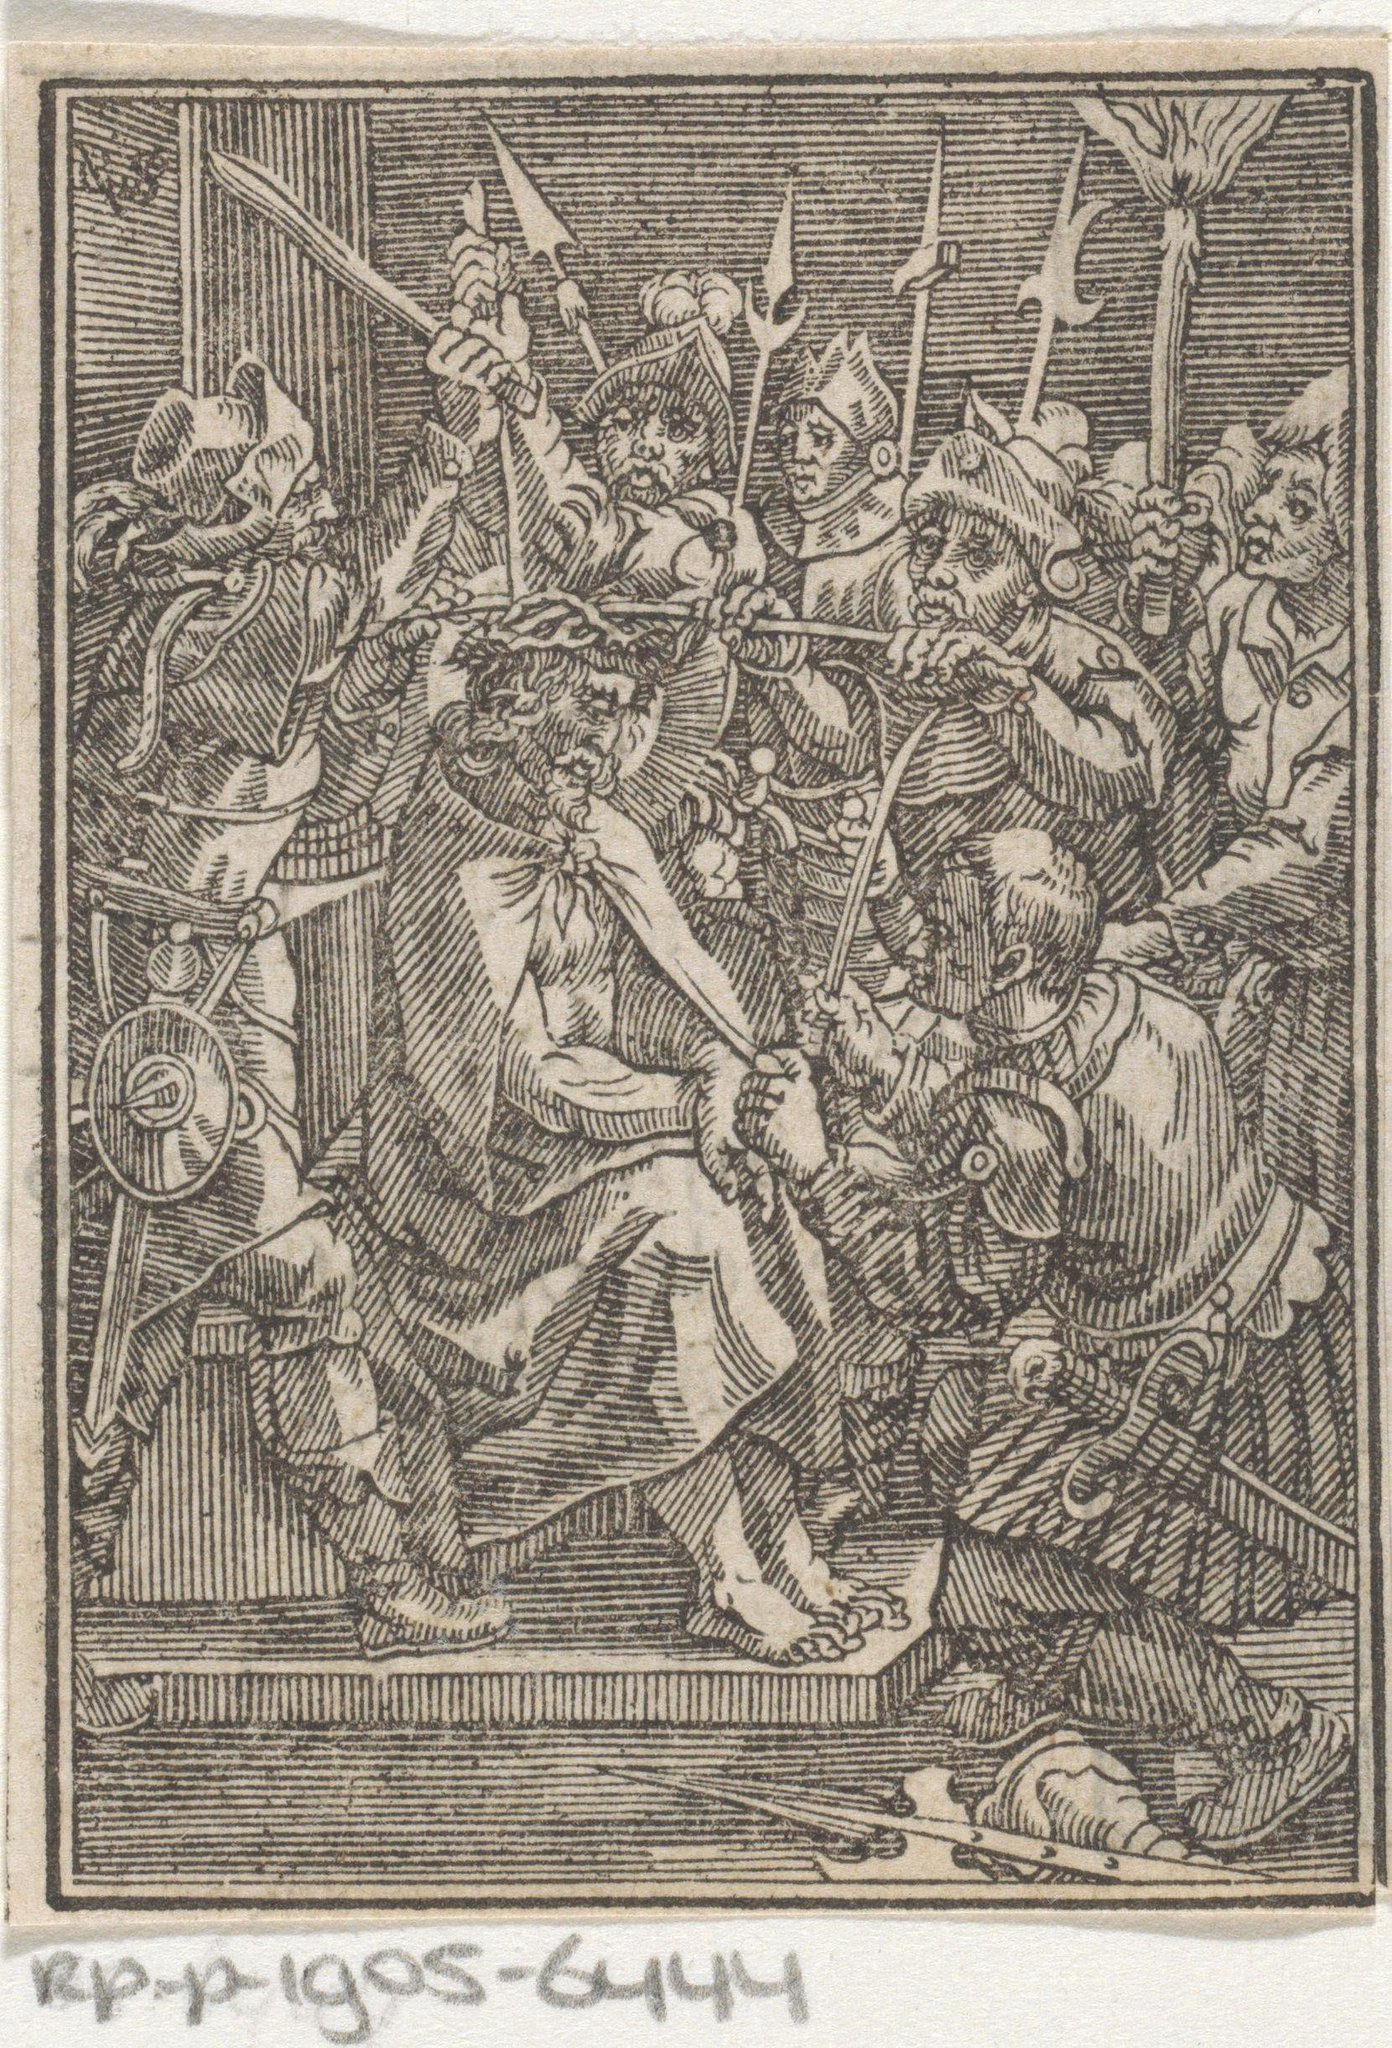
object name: book illustration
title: Doornenkroning van Christus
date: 1648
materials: paper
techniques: letterpress printing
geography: amsterdam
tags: the crowning with thorns: soldiers with sticks place a thorny crown on christ's head and give him a reed (matthew 27:27-31; mark 15:16-20; john 19:2-3)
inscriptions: collector's mark: Lugt 2228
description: Prent uit: Sichem, Christoffel van (II). 'tSchat der zielen, dat is: Het geheele leven ons Heeren Iesu Christi. Amsterdam: Pieter Jacobsz. Paets, 1648. Prent uit: Biblia sacra dat is De geheele Heylighe Schrifture bedeylt in 't Out en Nieu Testament. Amsterdam: Pieter Jacobsz. Paets, 1657.